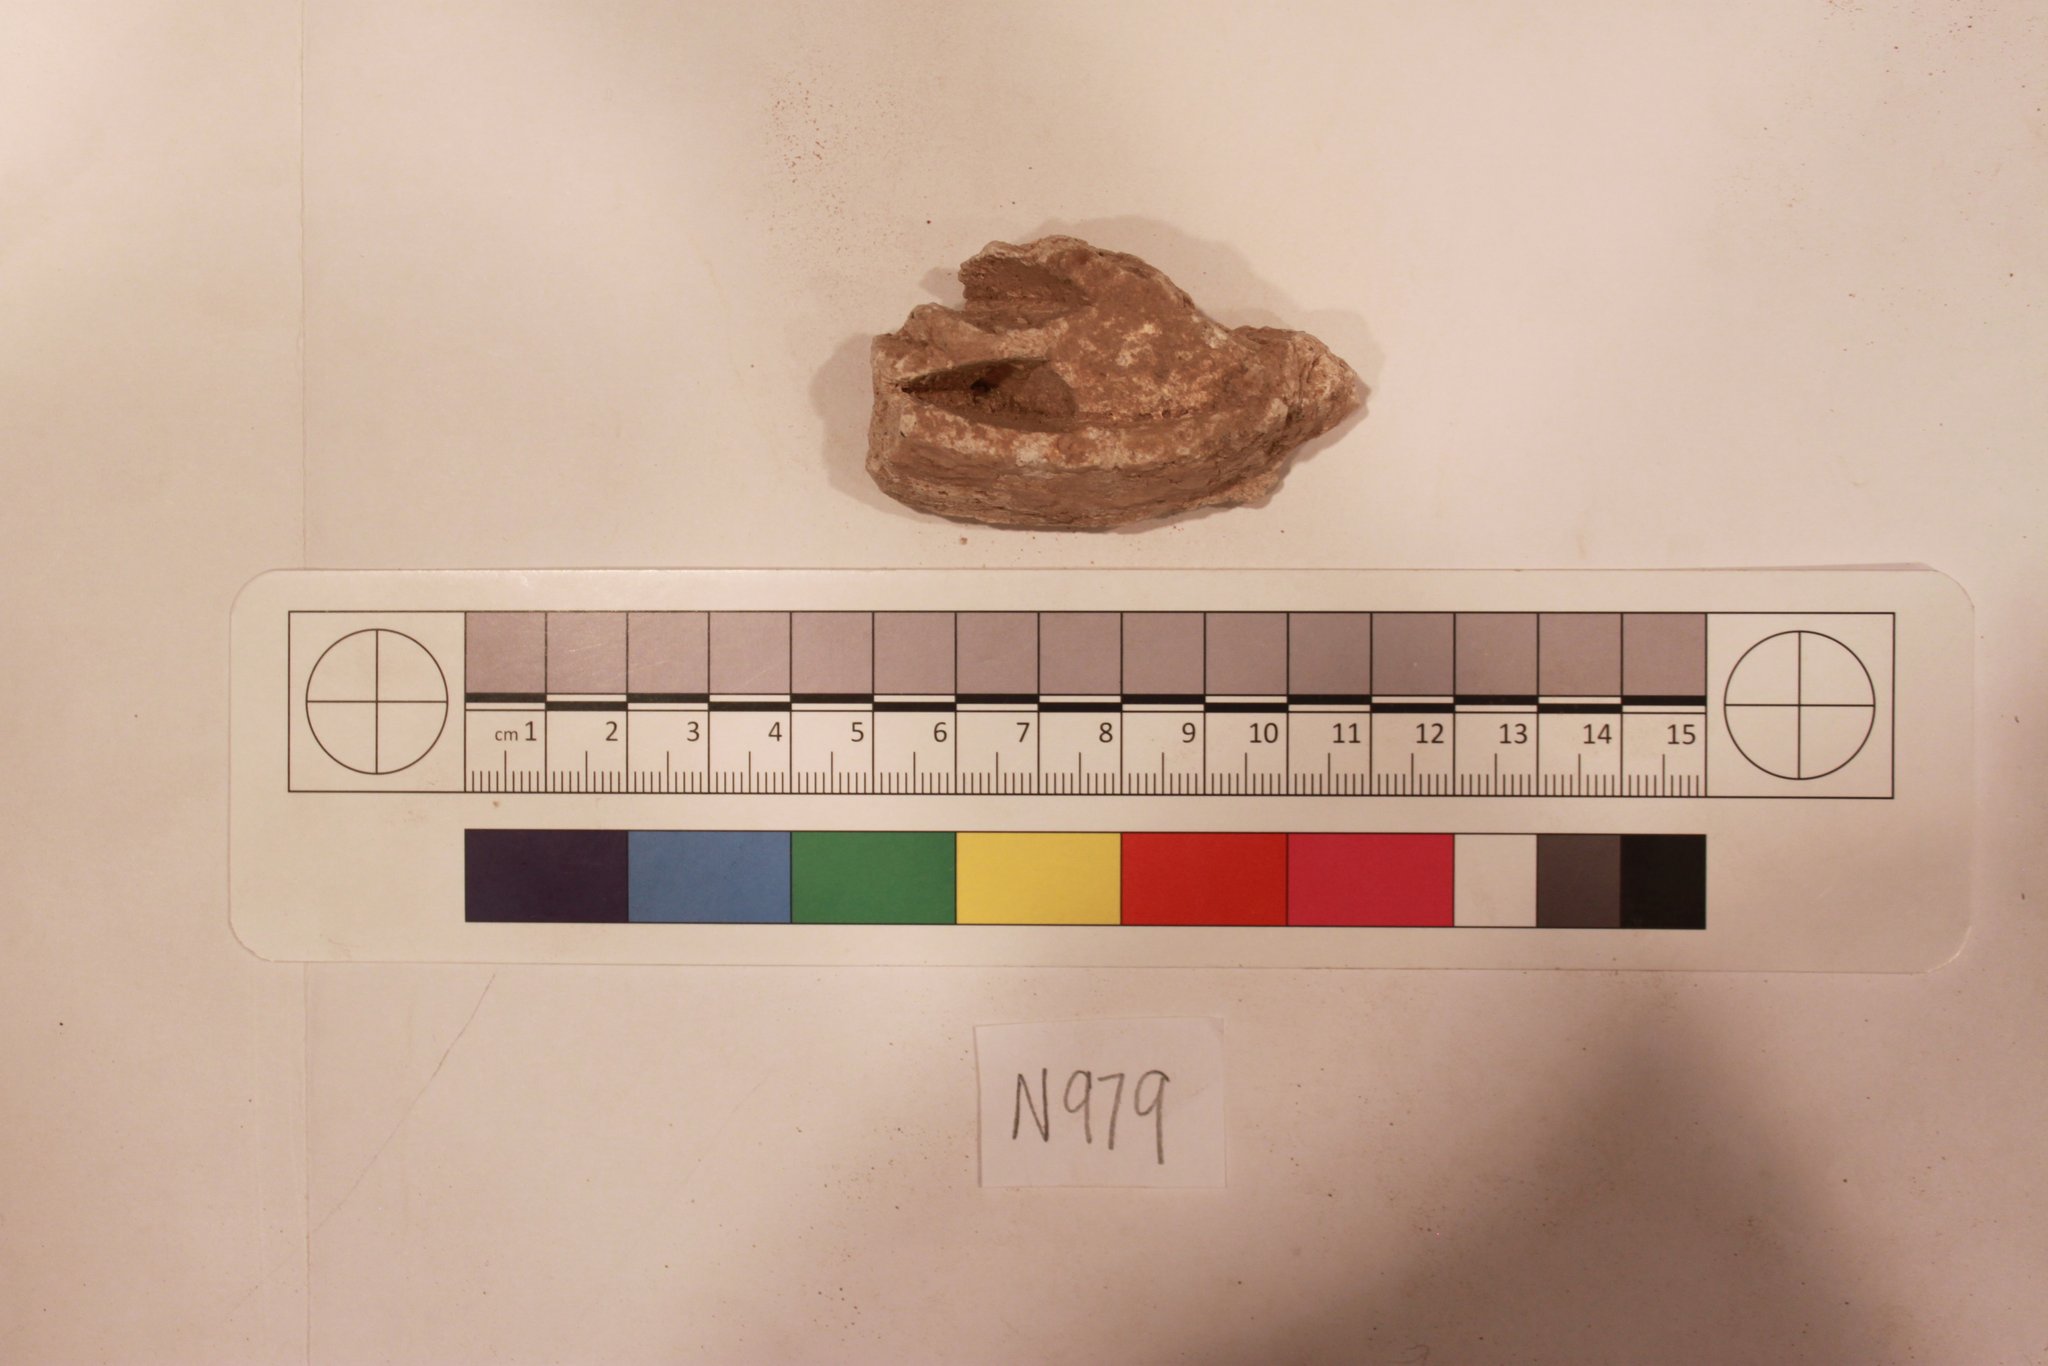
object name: fragment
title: Stucco Fragment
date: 701-1200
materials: plaster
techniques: carving, painting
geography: iran